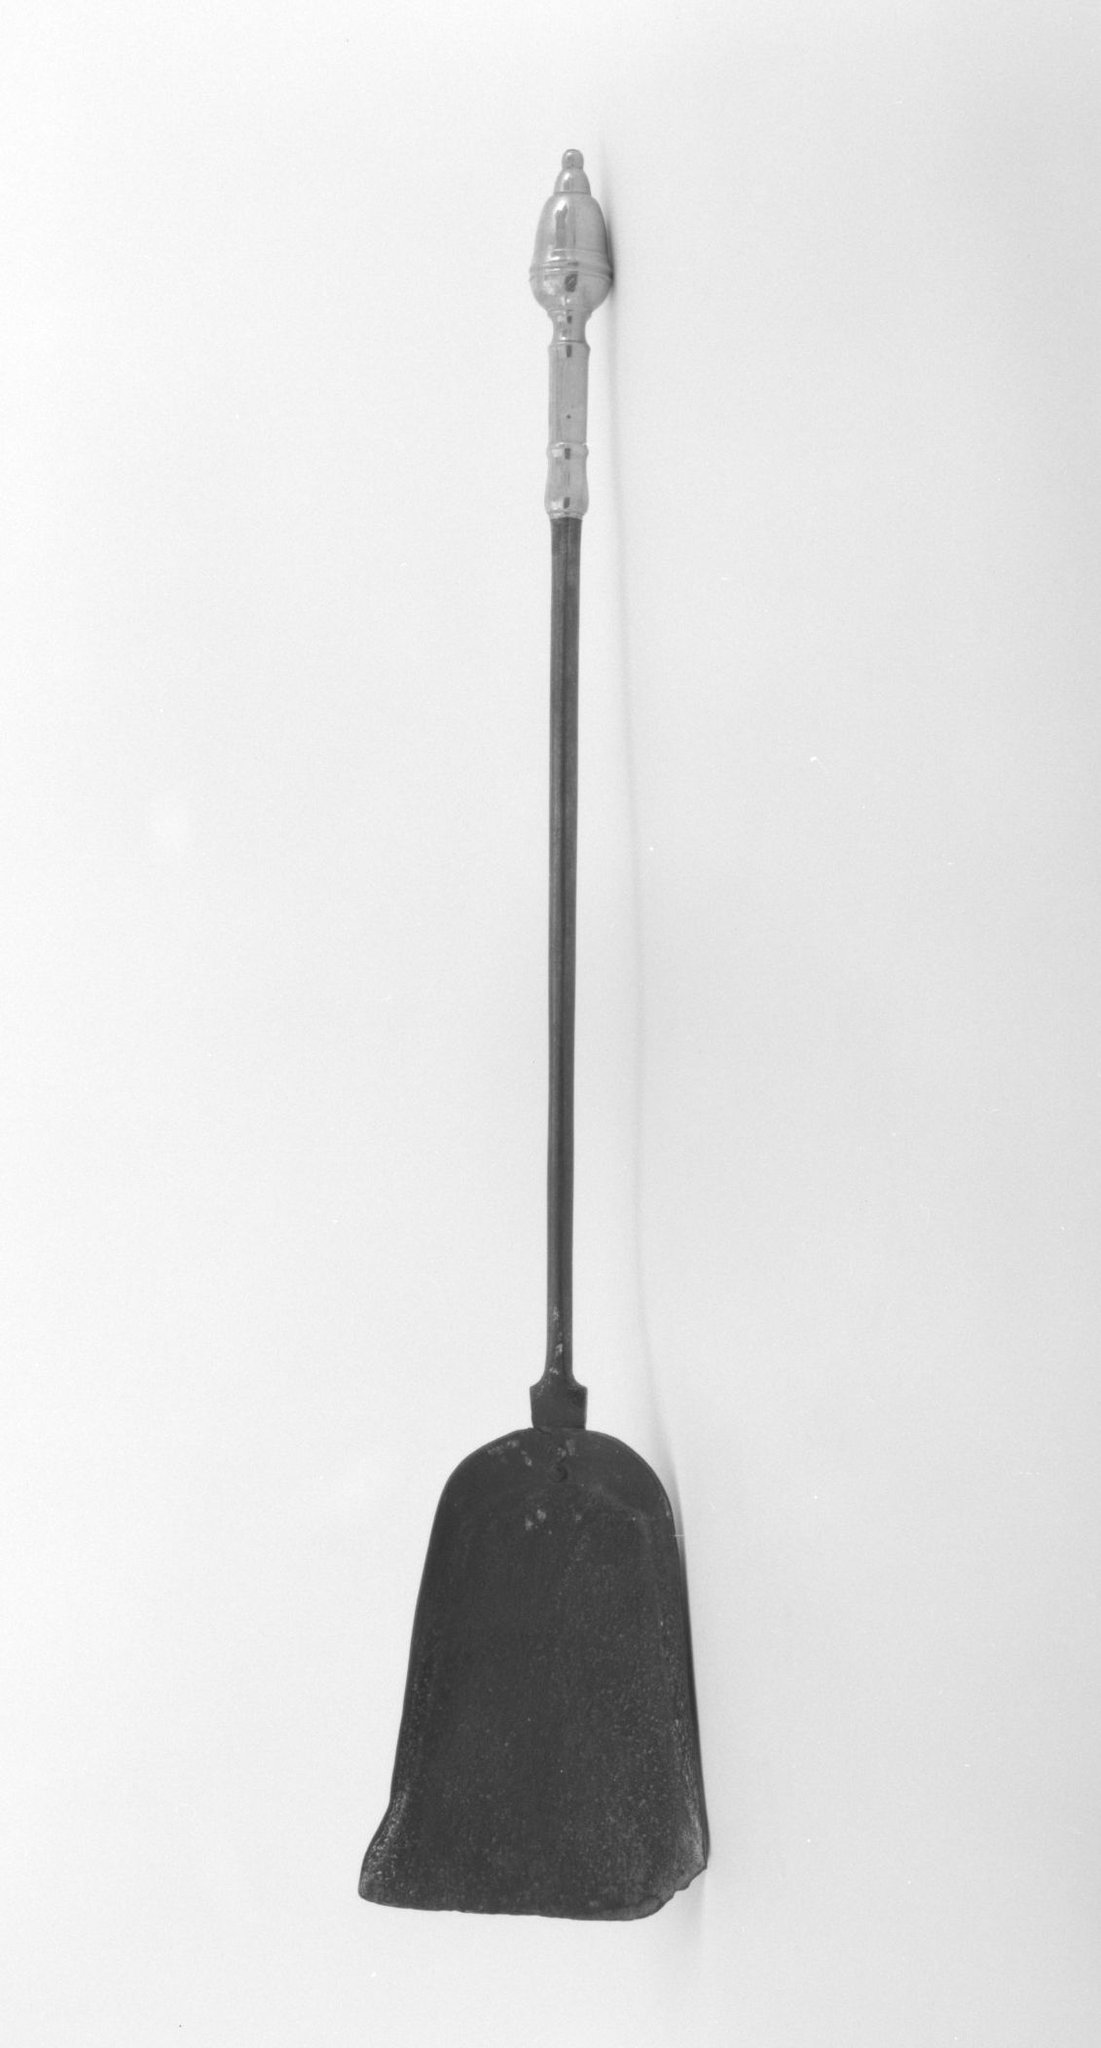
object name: fire shovel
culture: american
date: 1770-1800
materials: brass, iron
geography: united states